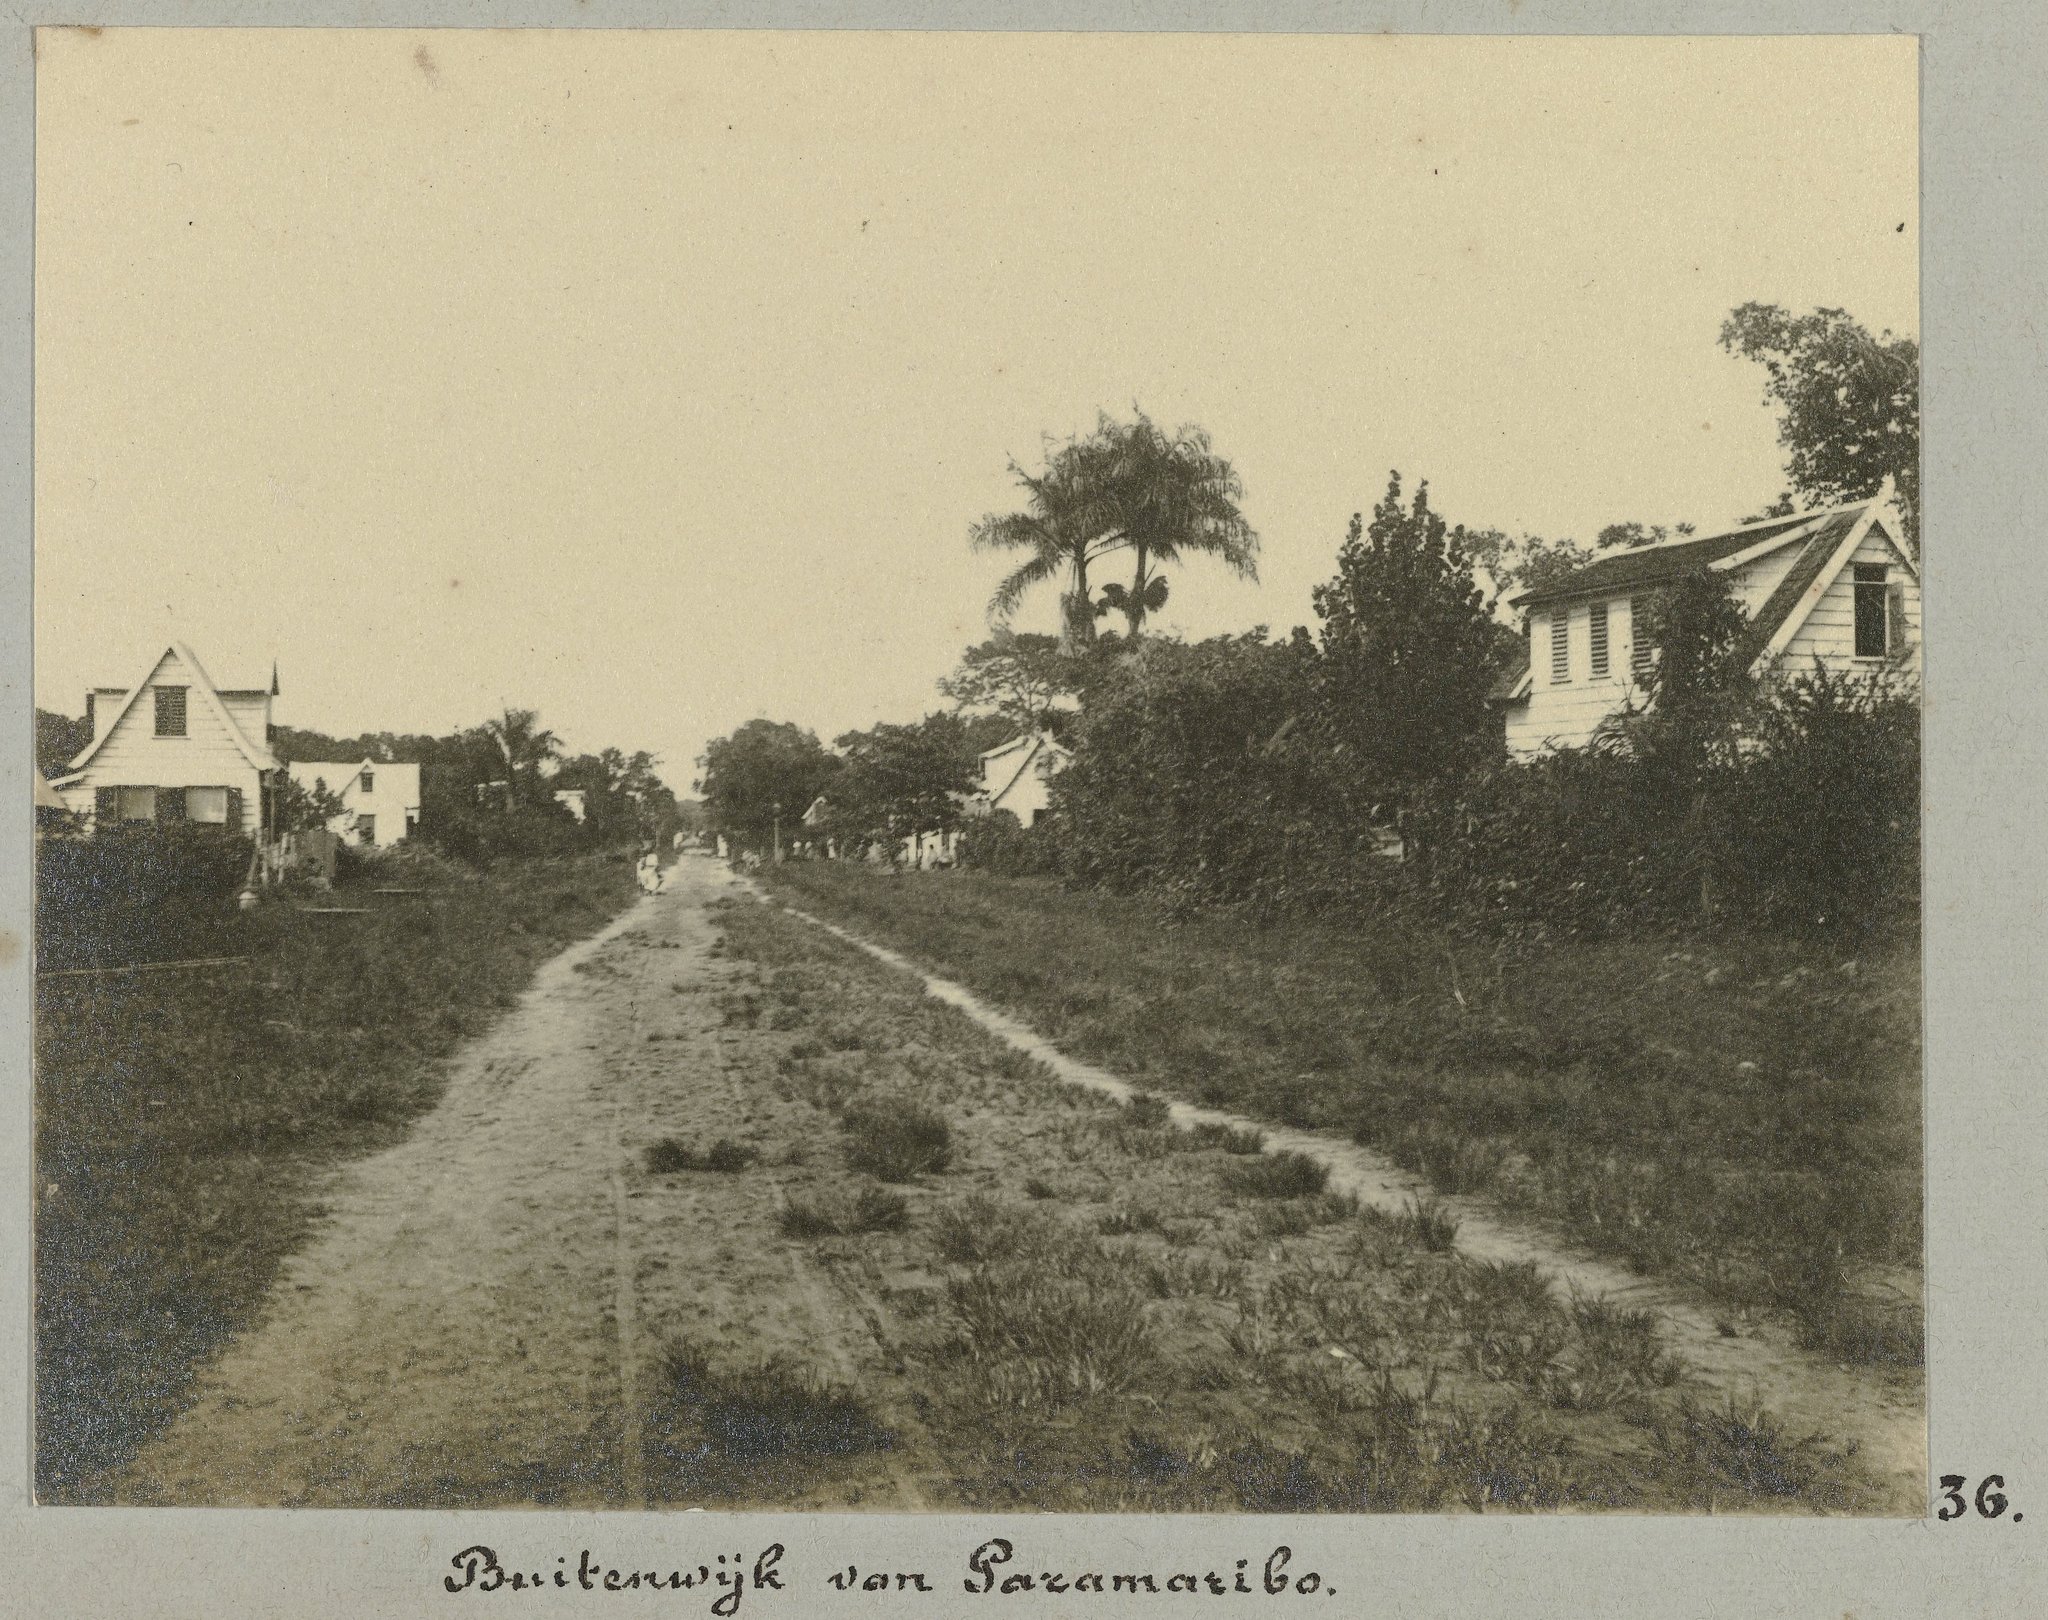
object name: photograph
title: Buitenwijk van Paramaribo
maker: hendrik doijer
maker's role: engineer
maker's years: 1863-1925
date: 1903-1910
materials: photographic support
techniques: gelatin silver print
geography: suriname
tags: suriname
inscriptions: inscription: ‘36. / Buitenwijk van Paramaribo.’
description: Gezicht op een weg door een buitenwijk van Paramaribo. Onderdeel van het fotoalbum Souvenir de Voyage (deel 2), over het leven van de familie Doijer in en rond de plantage Ma Retraite in Suriname in de jaren 1903-1910.